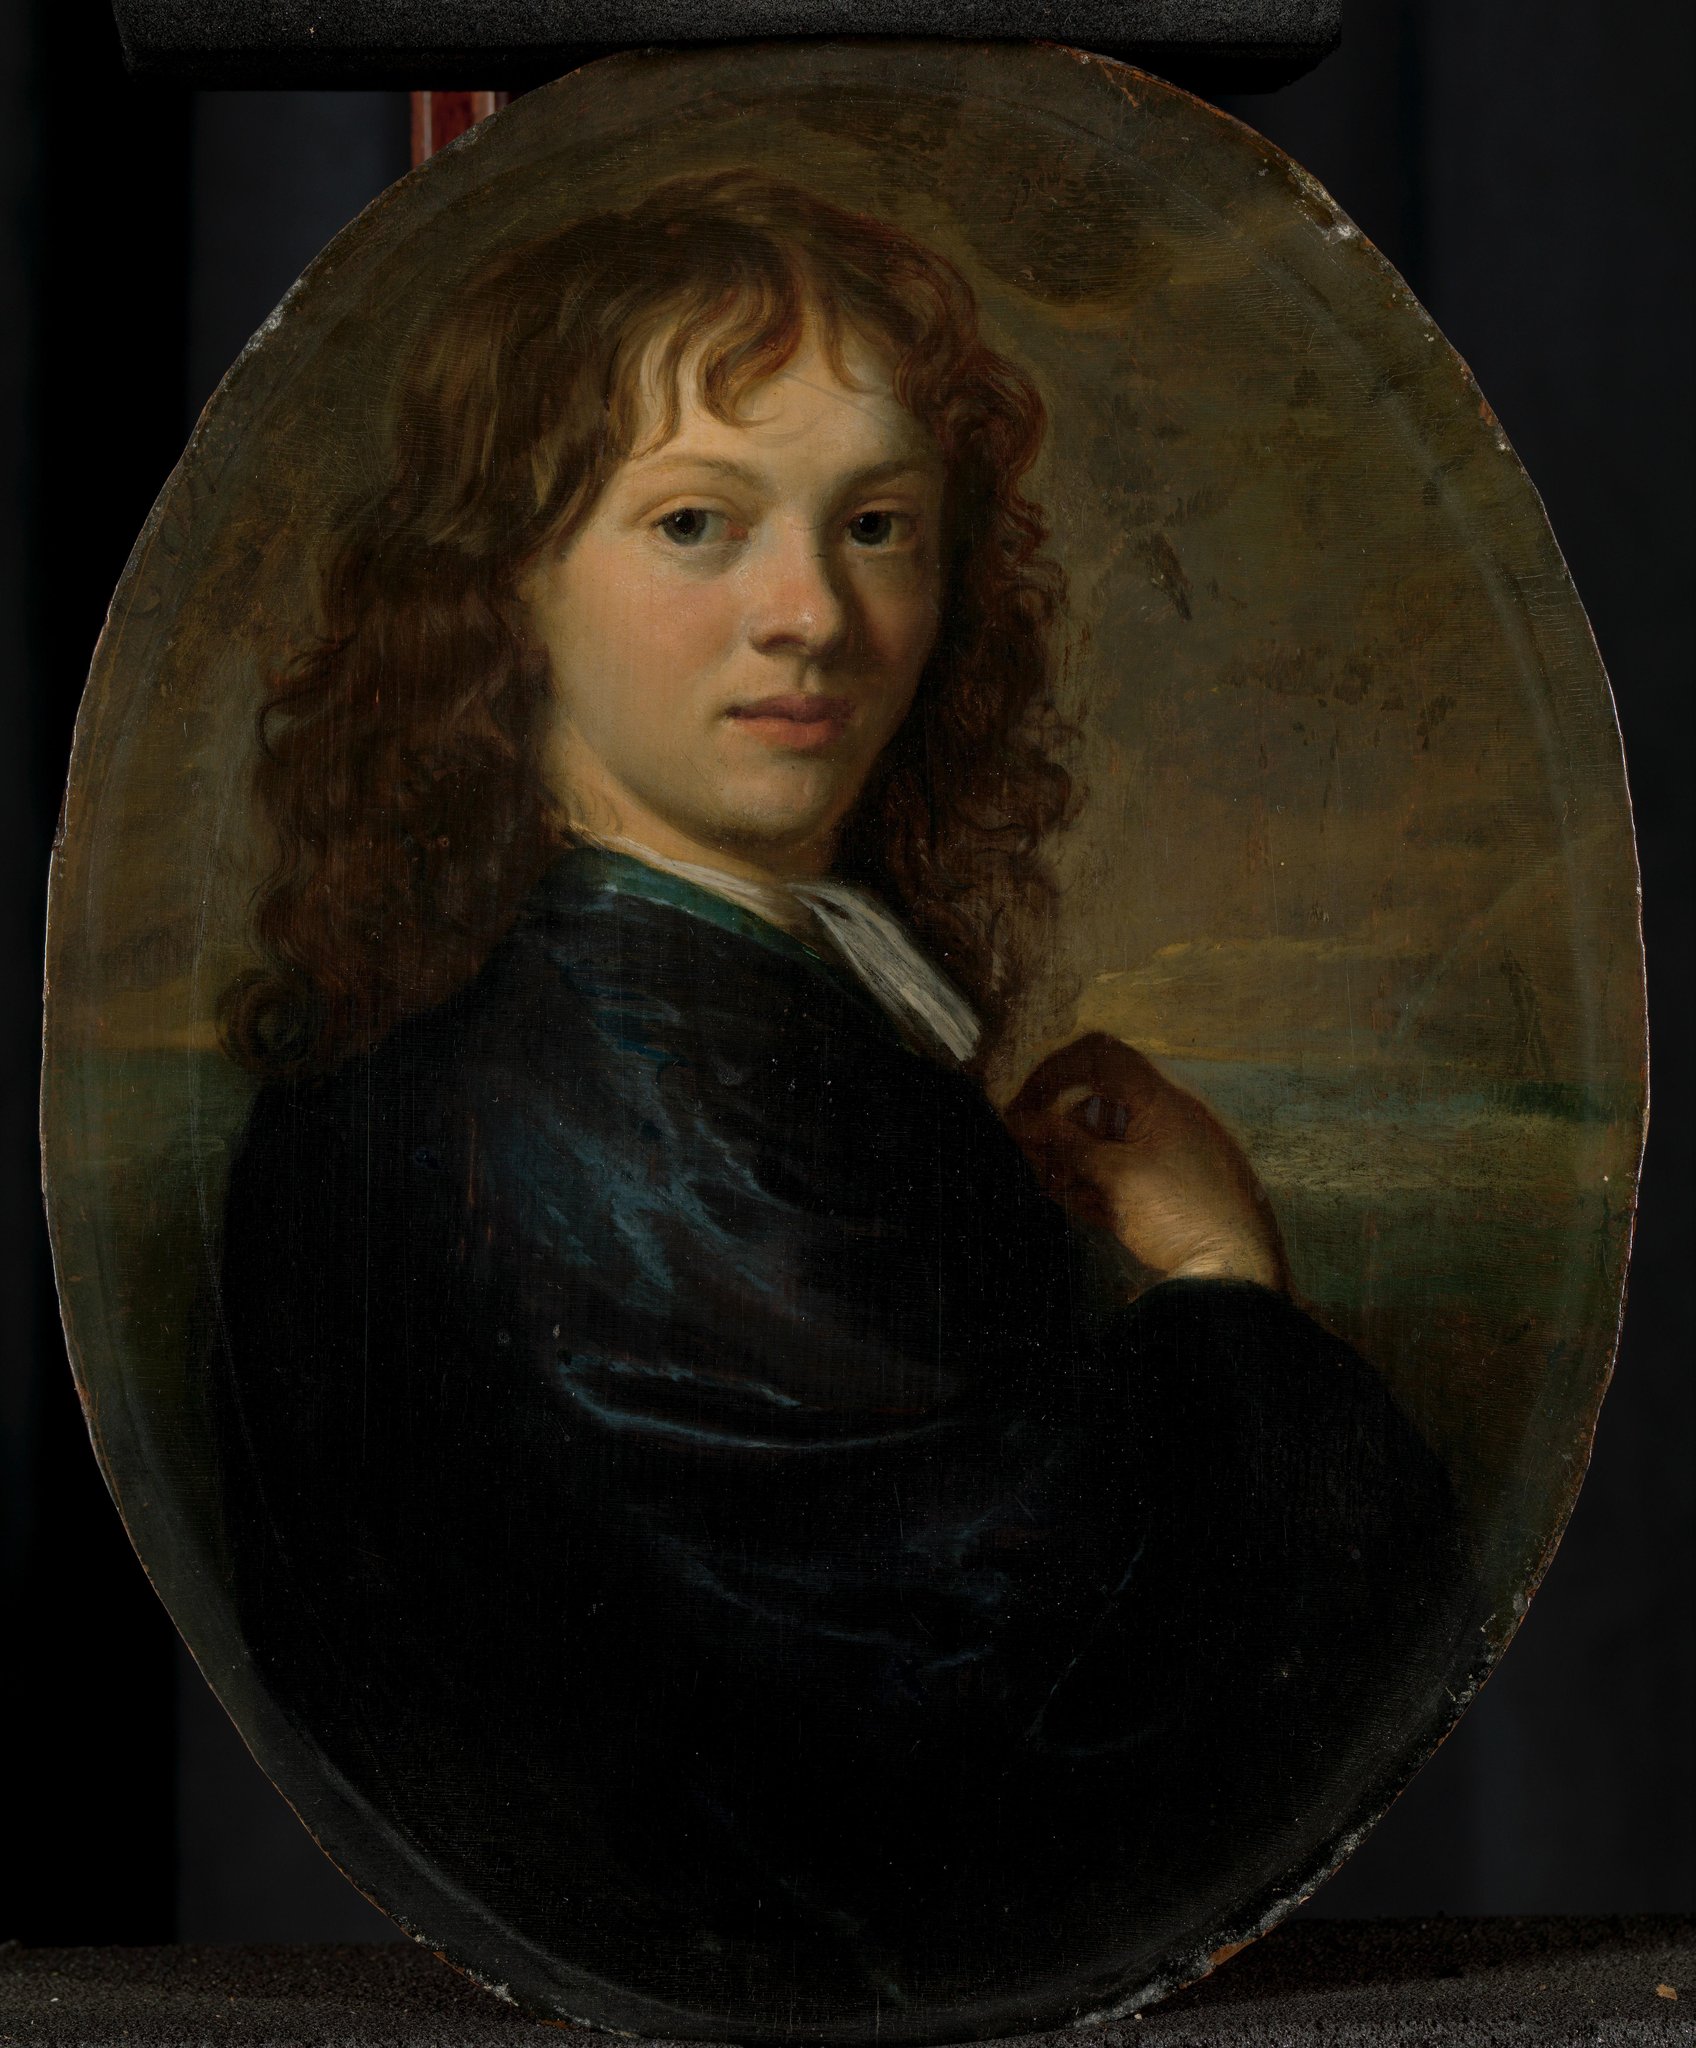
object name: painting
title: Self-Portrait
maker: carel de moor (ii)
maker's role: draughtsman, painter, print maker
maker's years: 1655-1738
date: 1675-1680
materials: oil, panel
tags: leiden, warmond, painter, print maker, draughtsman, carel de moor (ii), historical persons, portrait, self-portrait of painter, portrait, self-portrait of artist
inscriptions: signature: ‘C. d. Moor’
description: Zelfportret van de schilder Carel de Moor. Buste in ovaal, naar rechts.